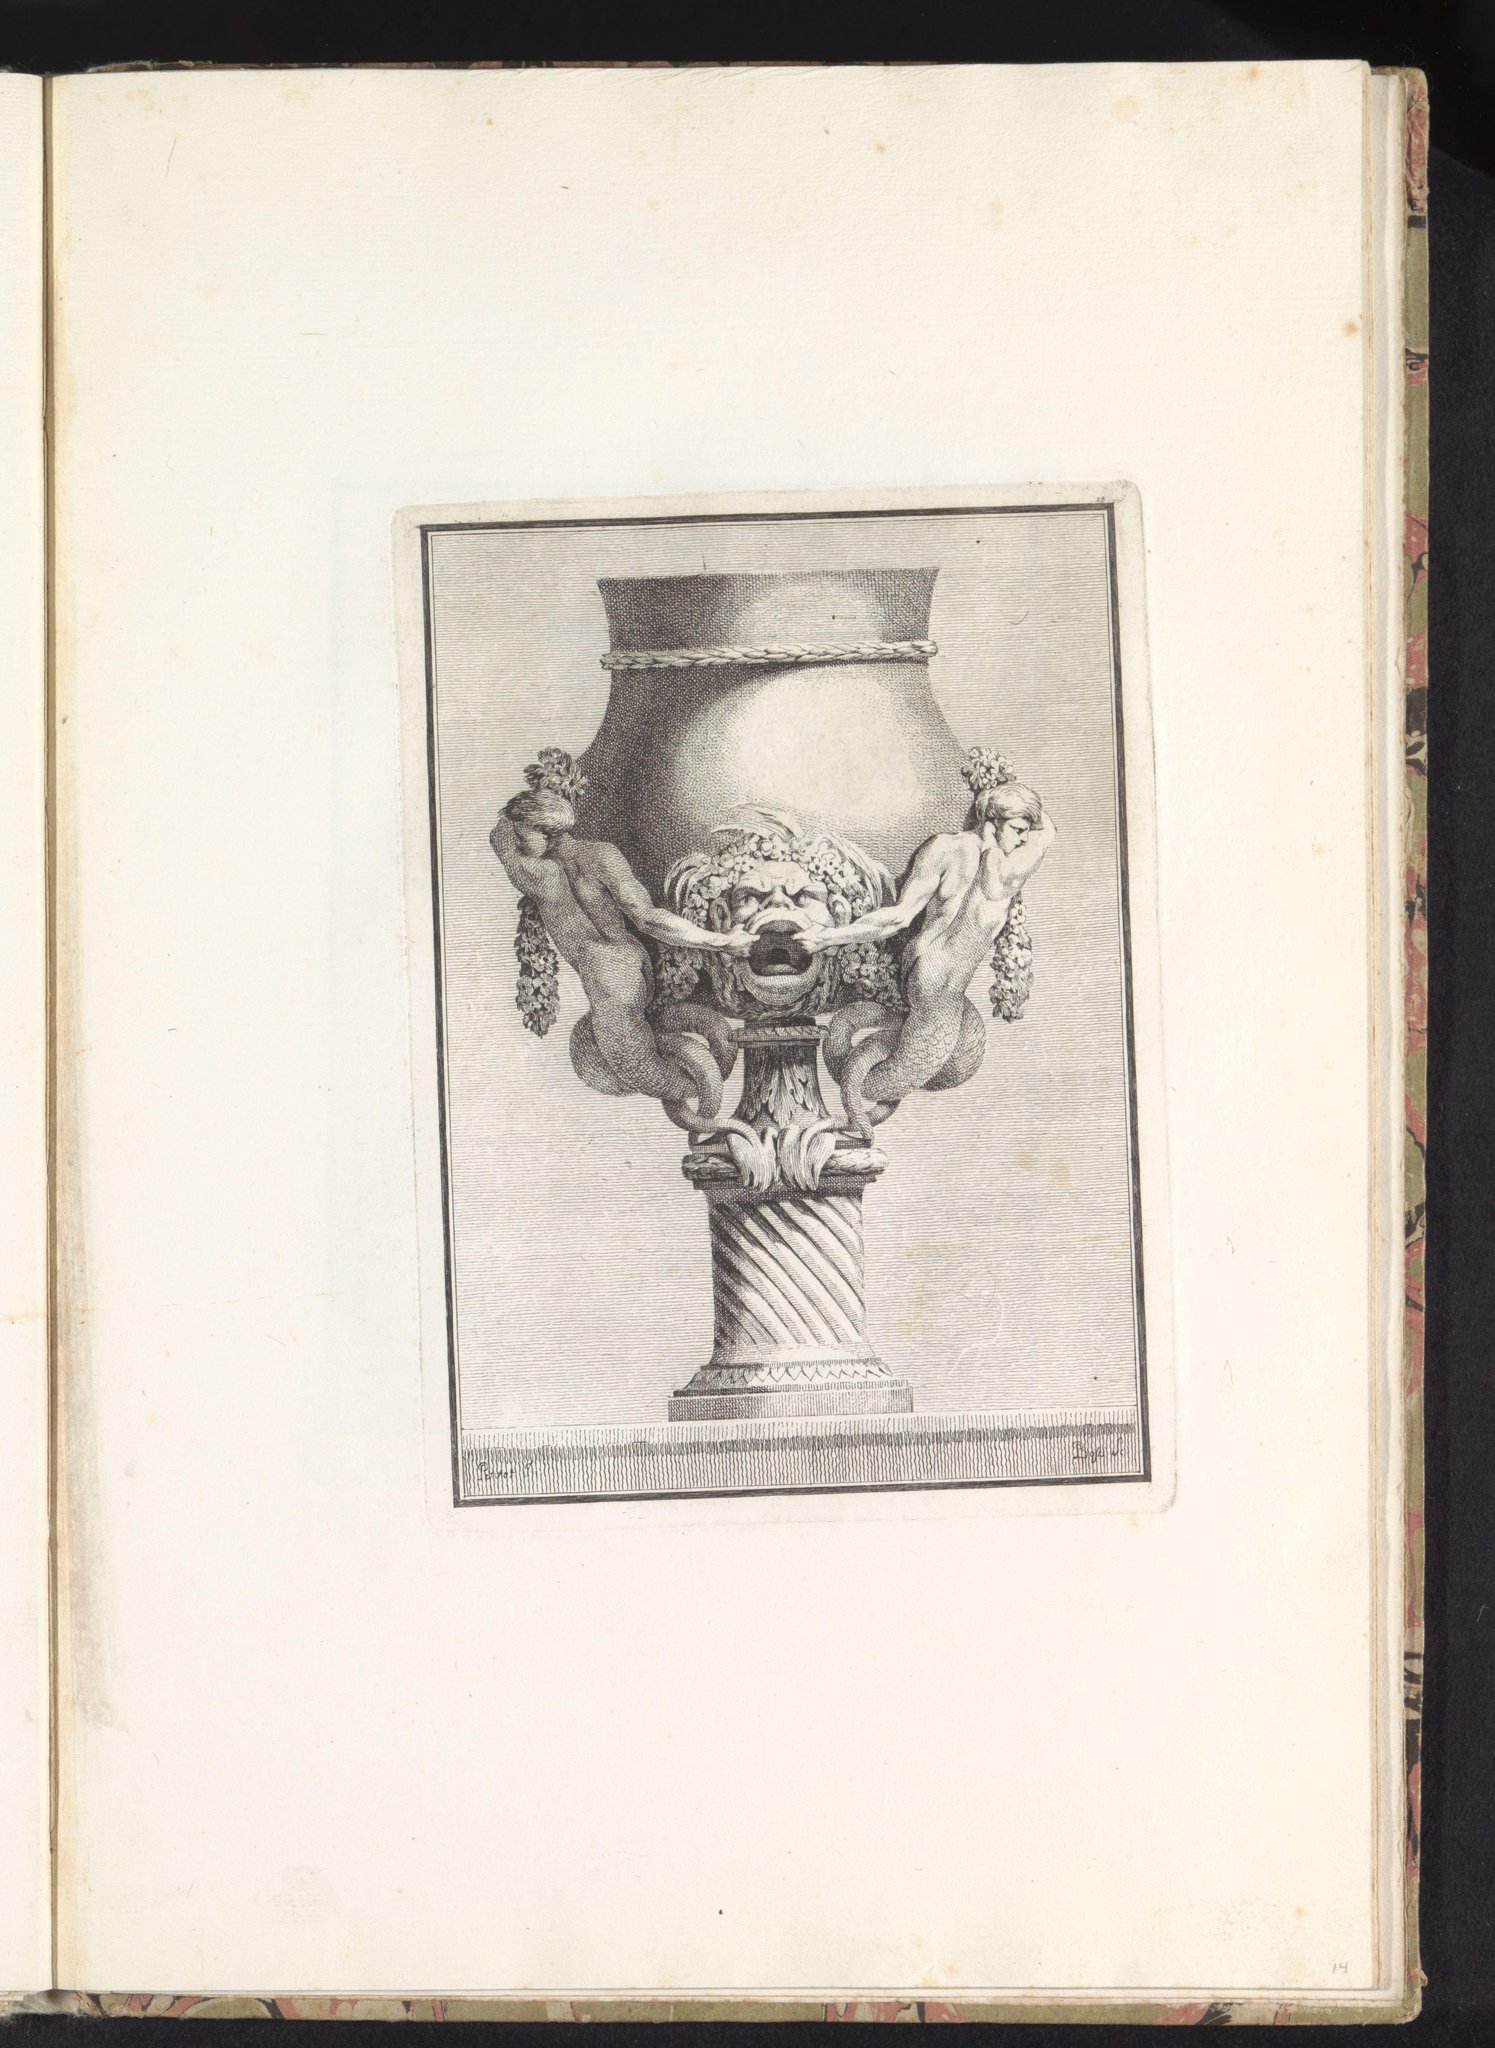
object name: ornament print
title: Bokaal met maskaron en twee meermannen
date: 1764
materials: paper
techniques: etching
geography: parma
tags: merman, vase ~ ornament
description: Bokaal op hoge geribde voet waarop twee meermannen, die zich vasthouden aan de open mond van een maskaron en een guirlande. De bokaal staat op een muur. No. 15 uit serie van 31. Prent maakt deel uit van een album. Gedrukt recto rechtsboven: 15.